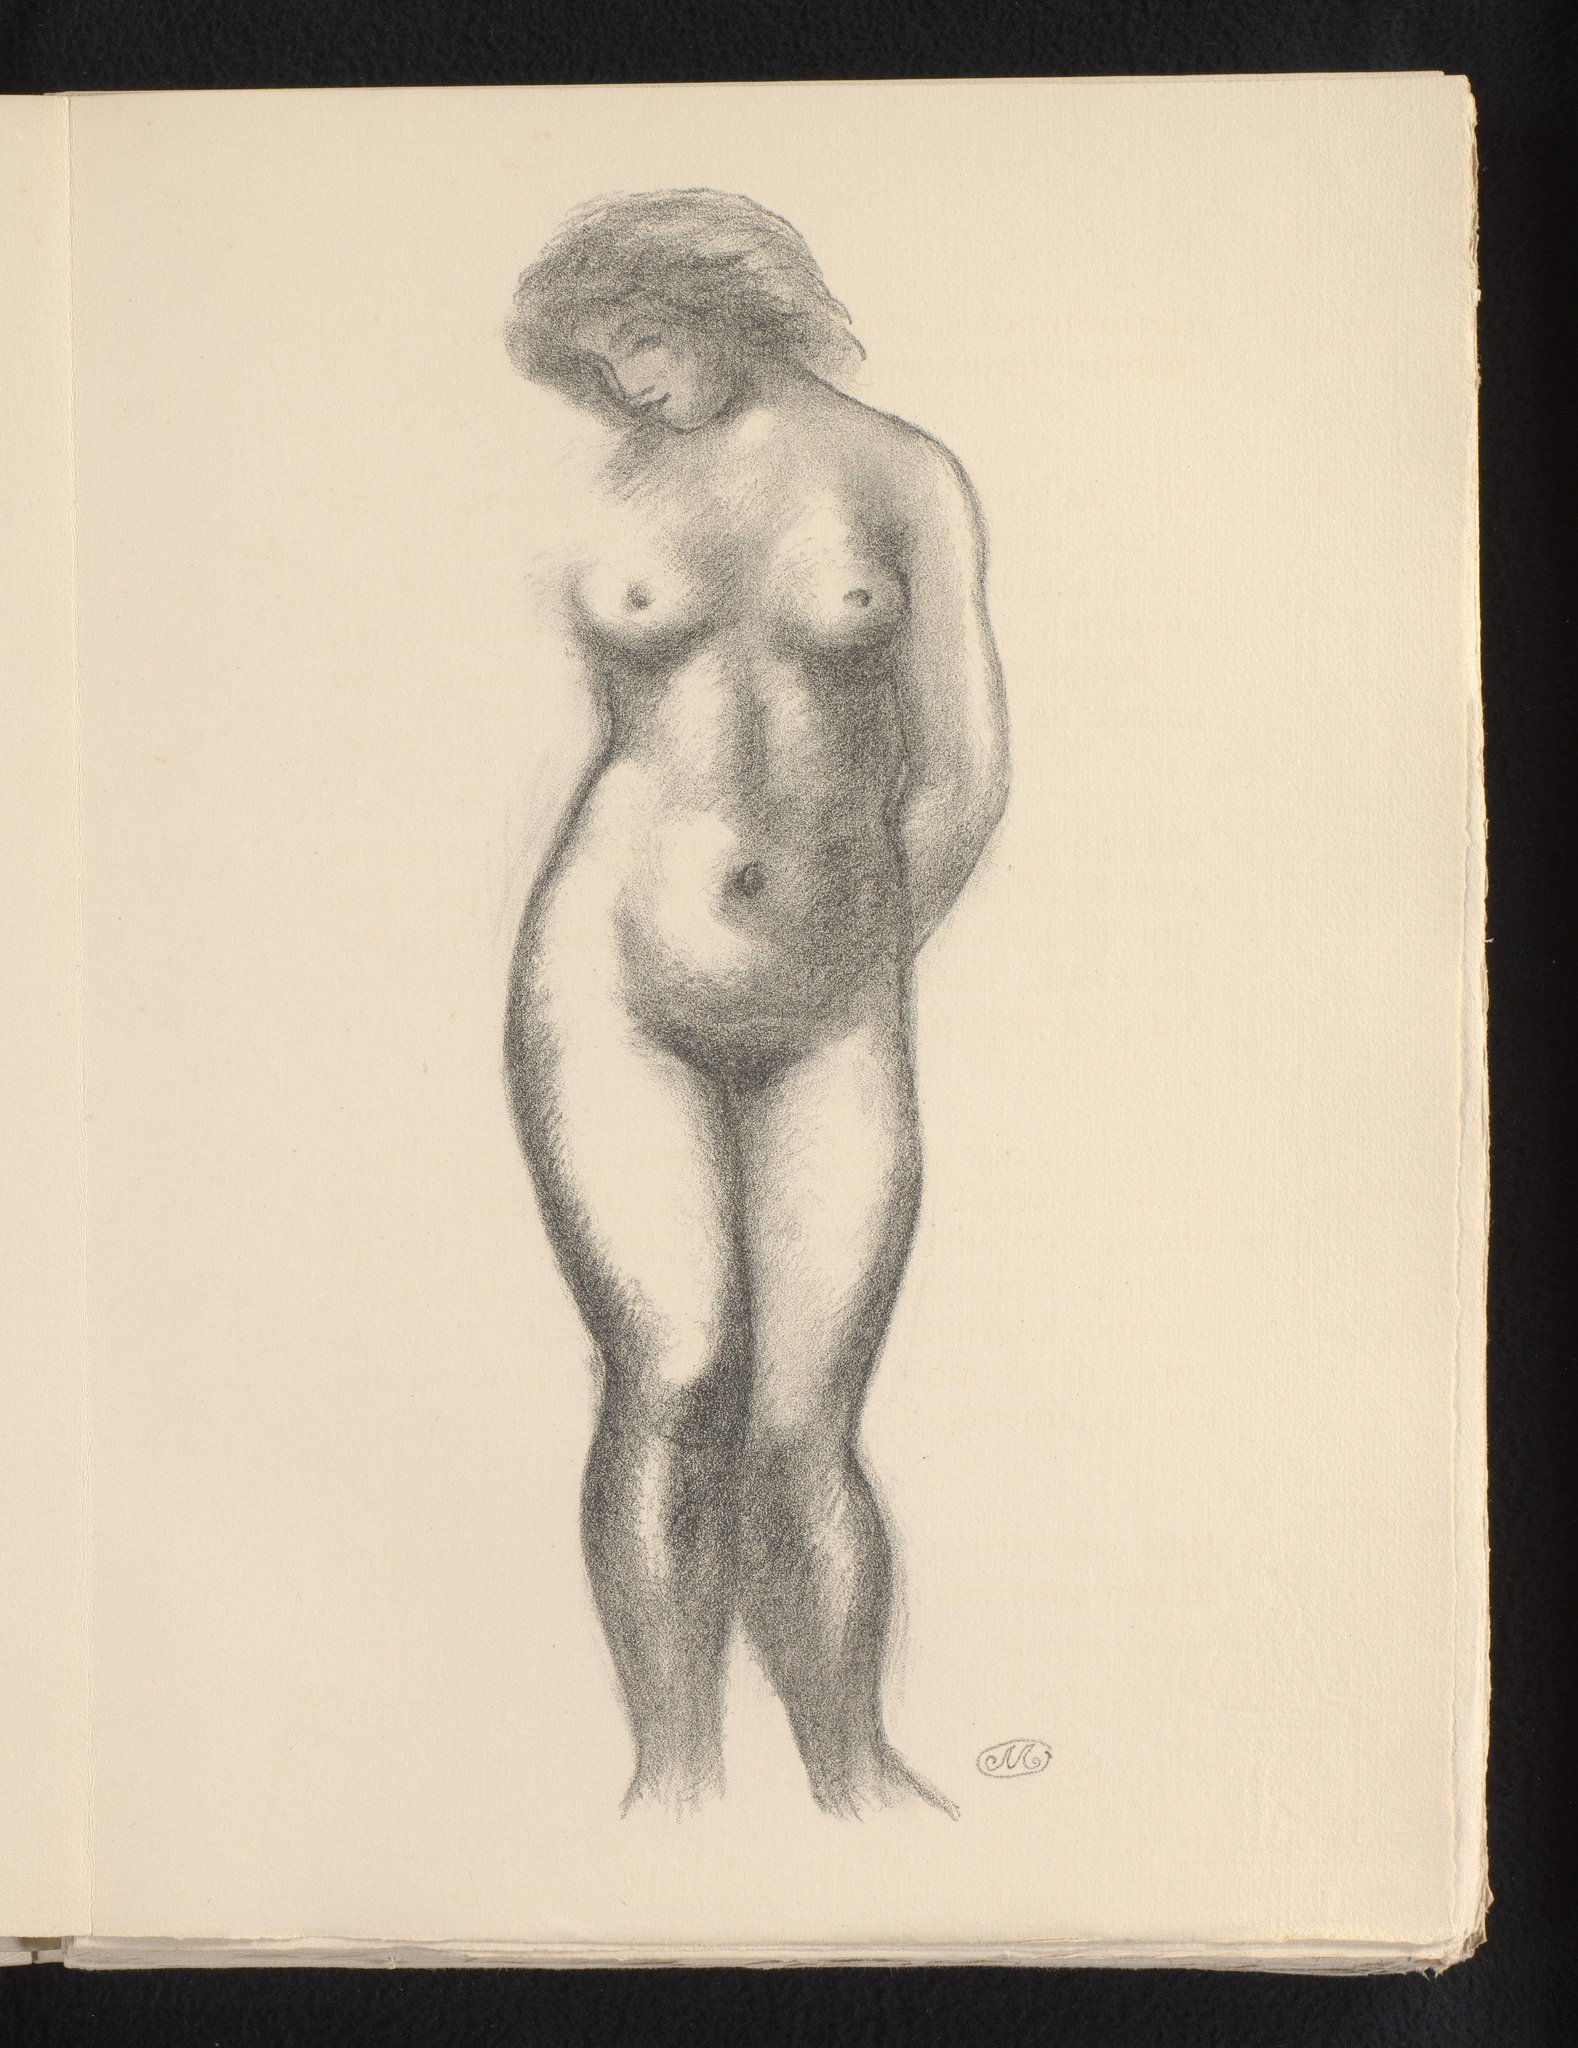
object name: book illustration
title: Staande naakte vrouw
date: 1948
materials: paper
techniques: letterpress printing, lithograph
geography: paris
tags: woman (showing herself) undressed, quasi-nude, standing figure - aa - female human figure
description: Prent uit: Lucianus van Samosata. Dialogues des Courtisanes. [Vertaald uit het Grieks door] Charles Astruc. Parijs: s.n., 1948, p. 21.